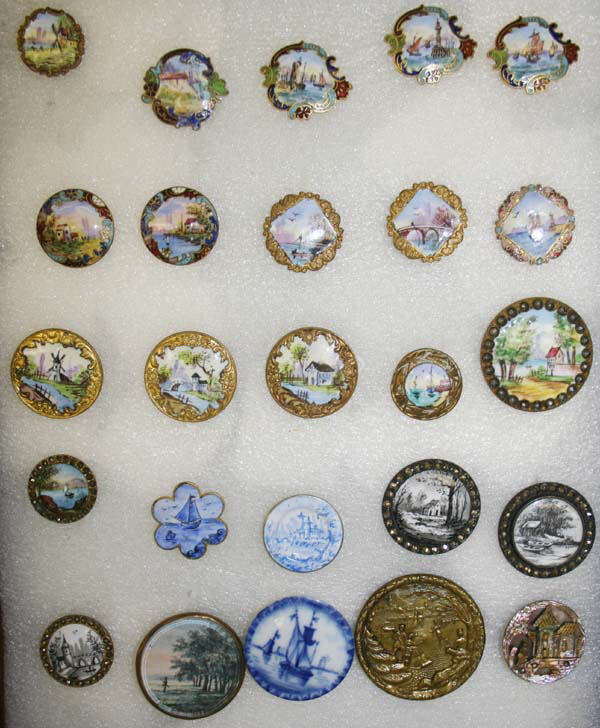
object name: button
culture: american or european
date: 1845-1895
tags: landscapes